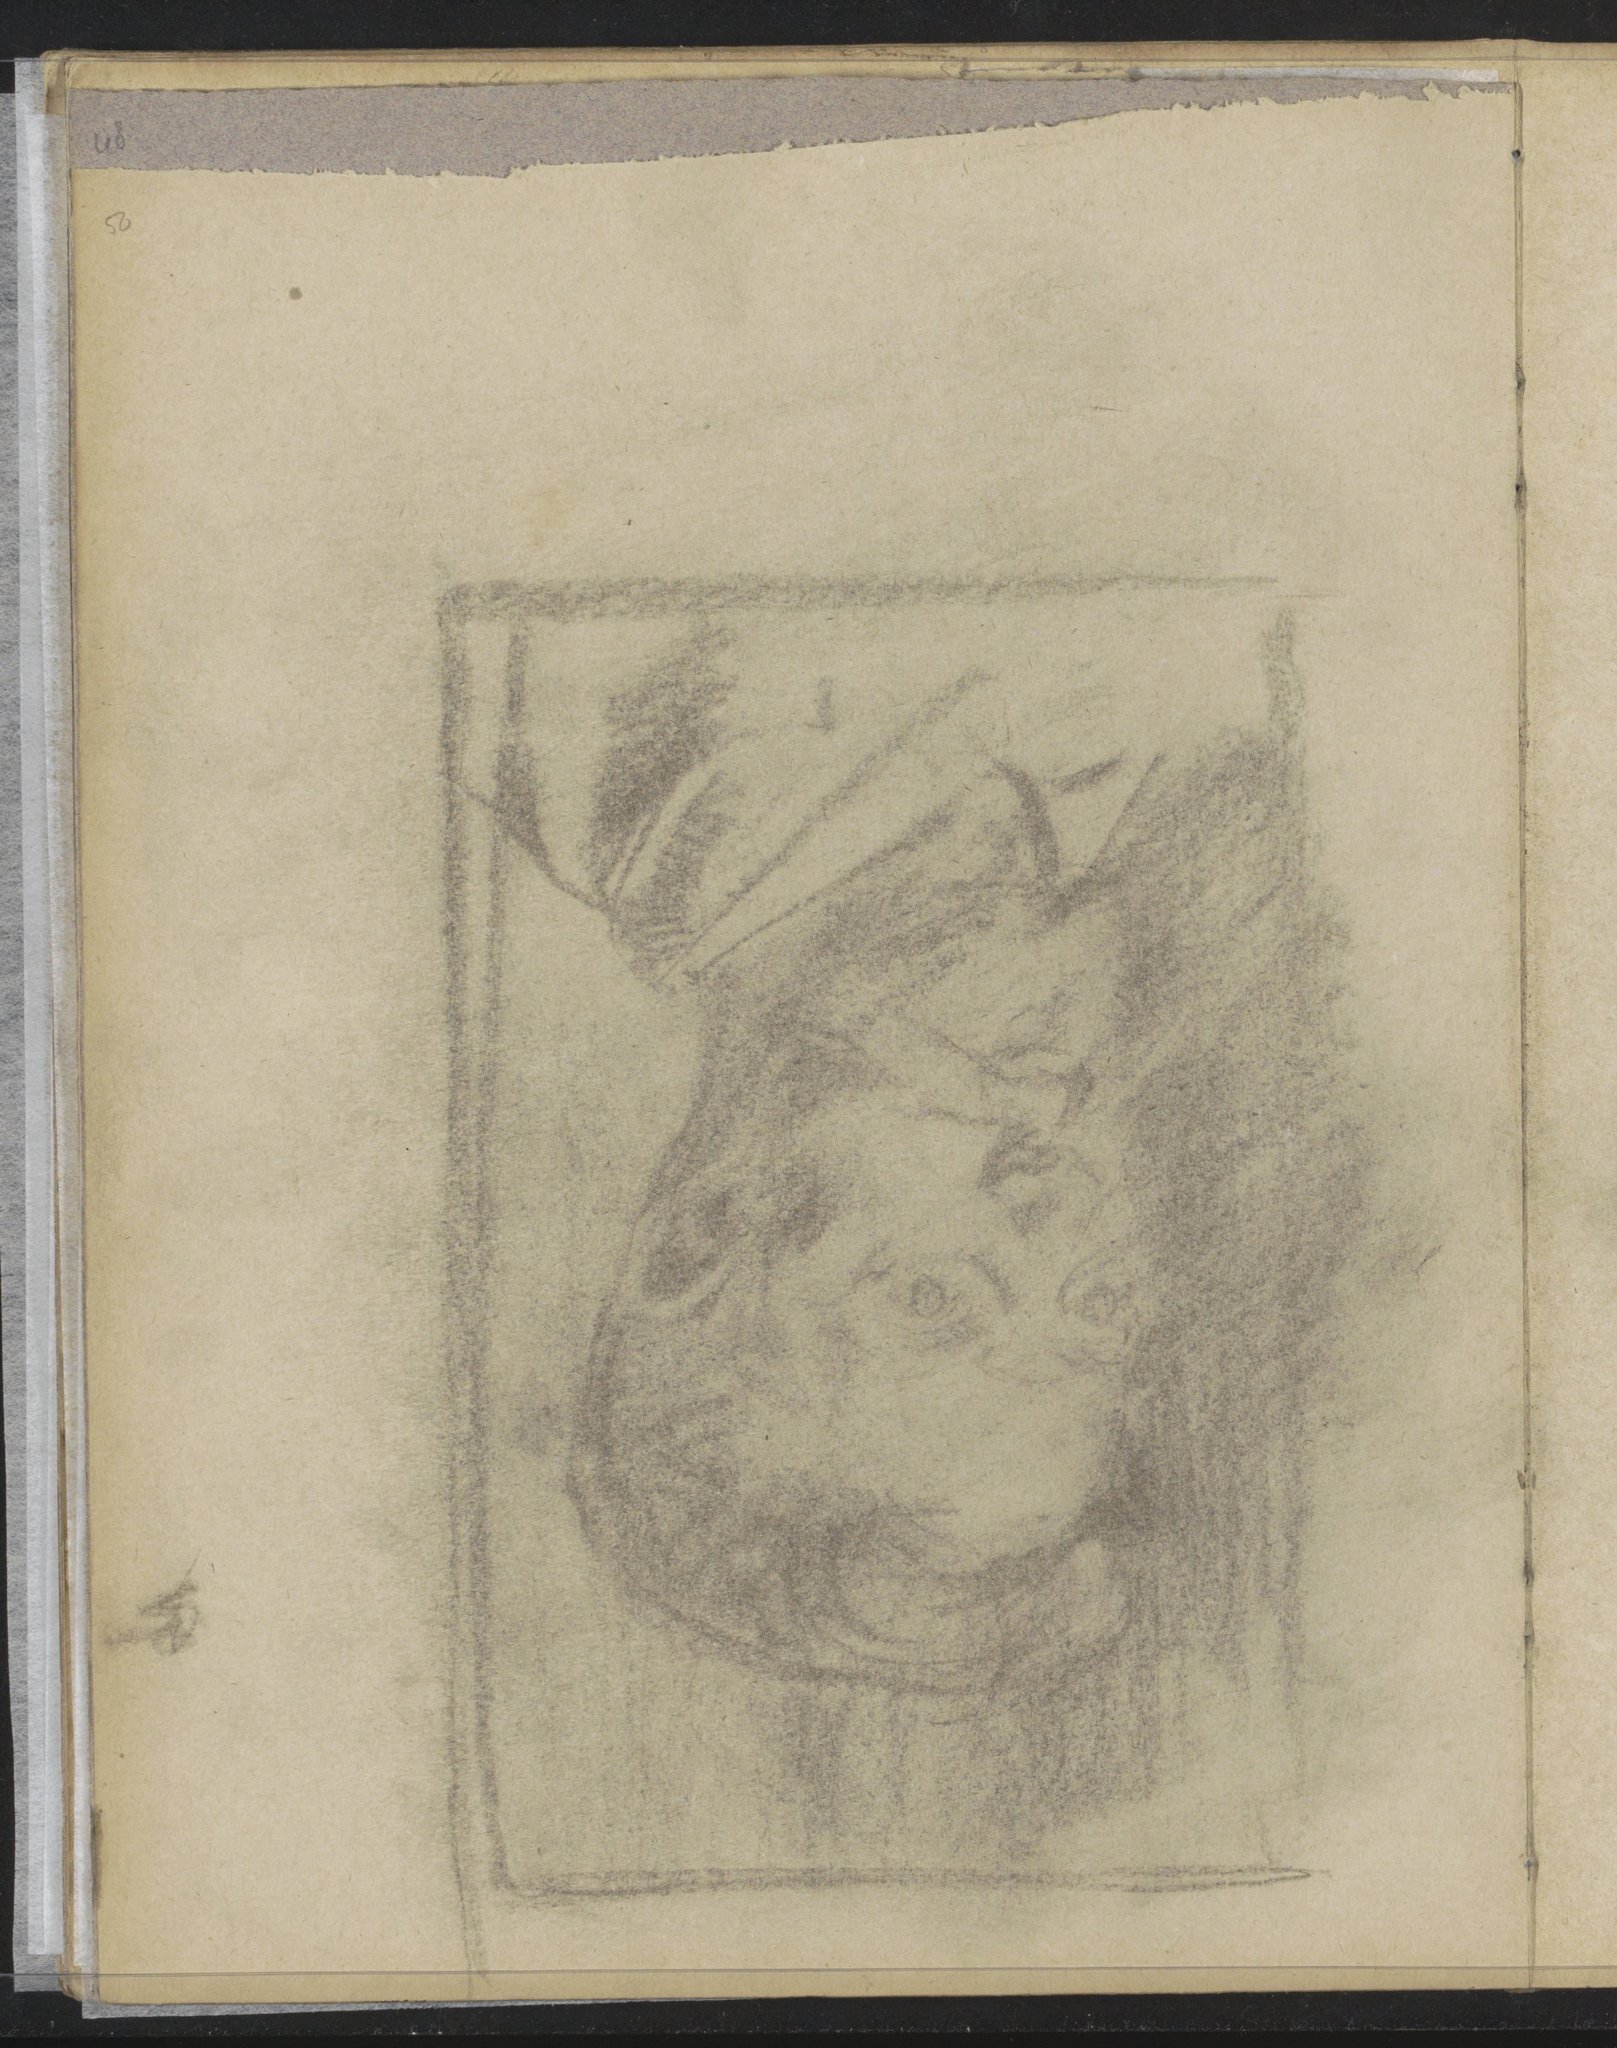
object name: sketchbook leaf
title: Portret van een onbekende man met bril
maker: willem witsen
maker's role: draughtsman, painter, print maker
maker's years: 1860-1923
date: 1886-1891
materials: chalk, paper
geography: london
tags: eyeglasses, spectacles, anonymous historical person portrayed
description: Pagina 50 uit een schetsboek met 40 bladen.